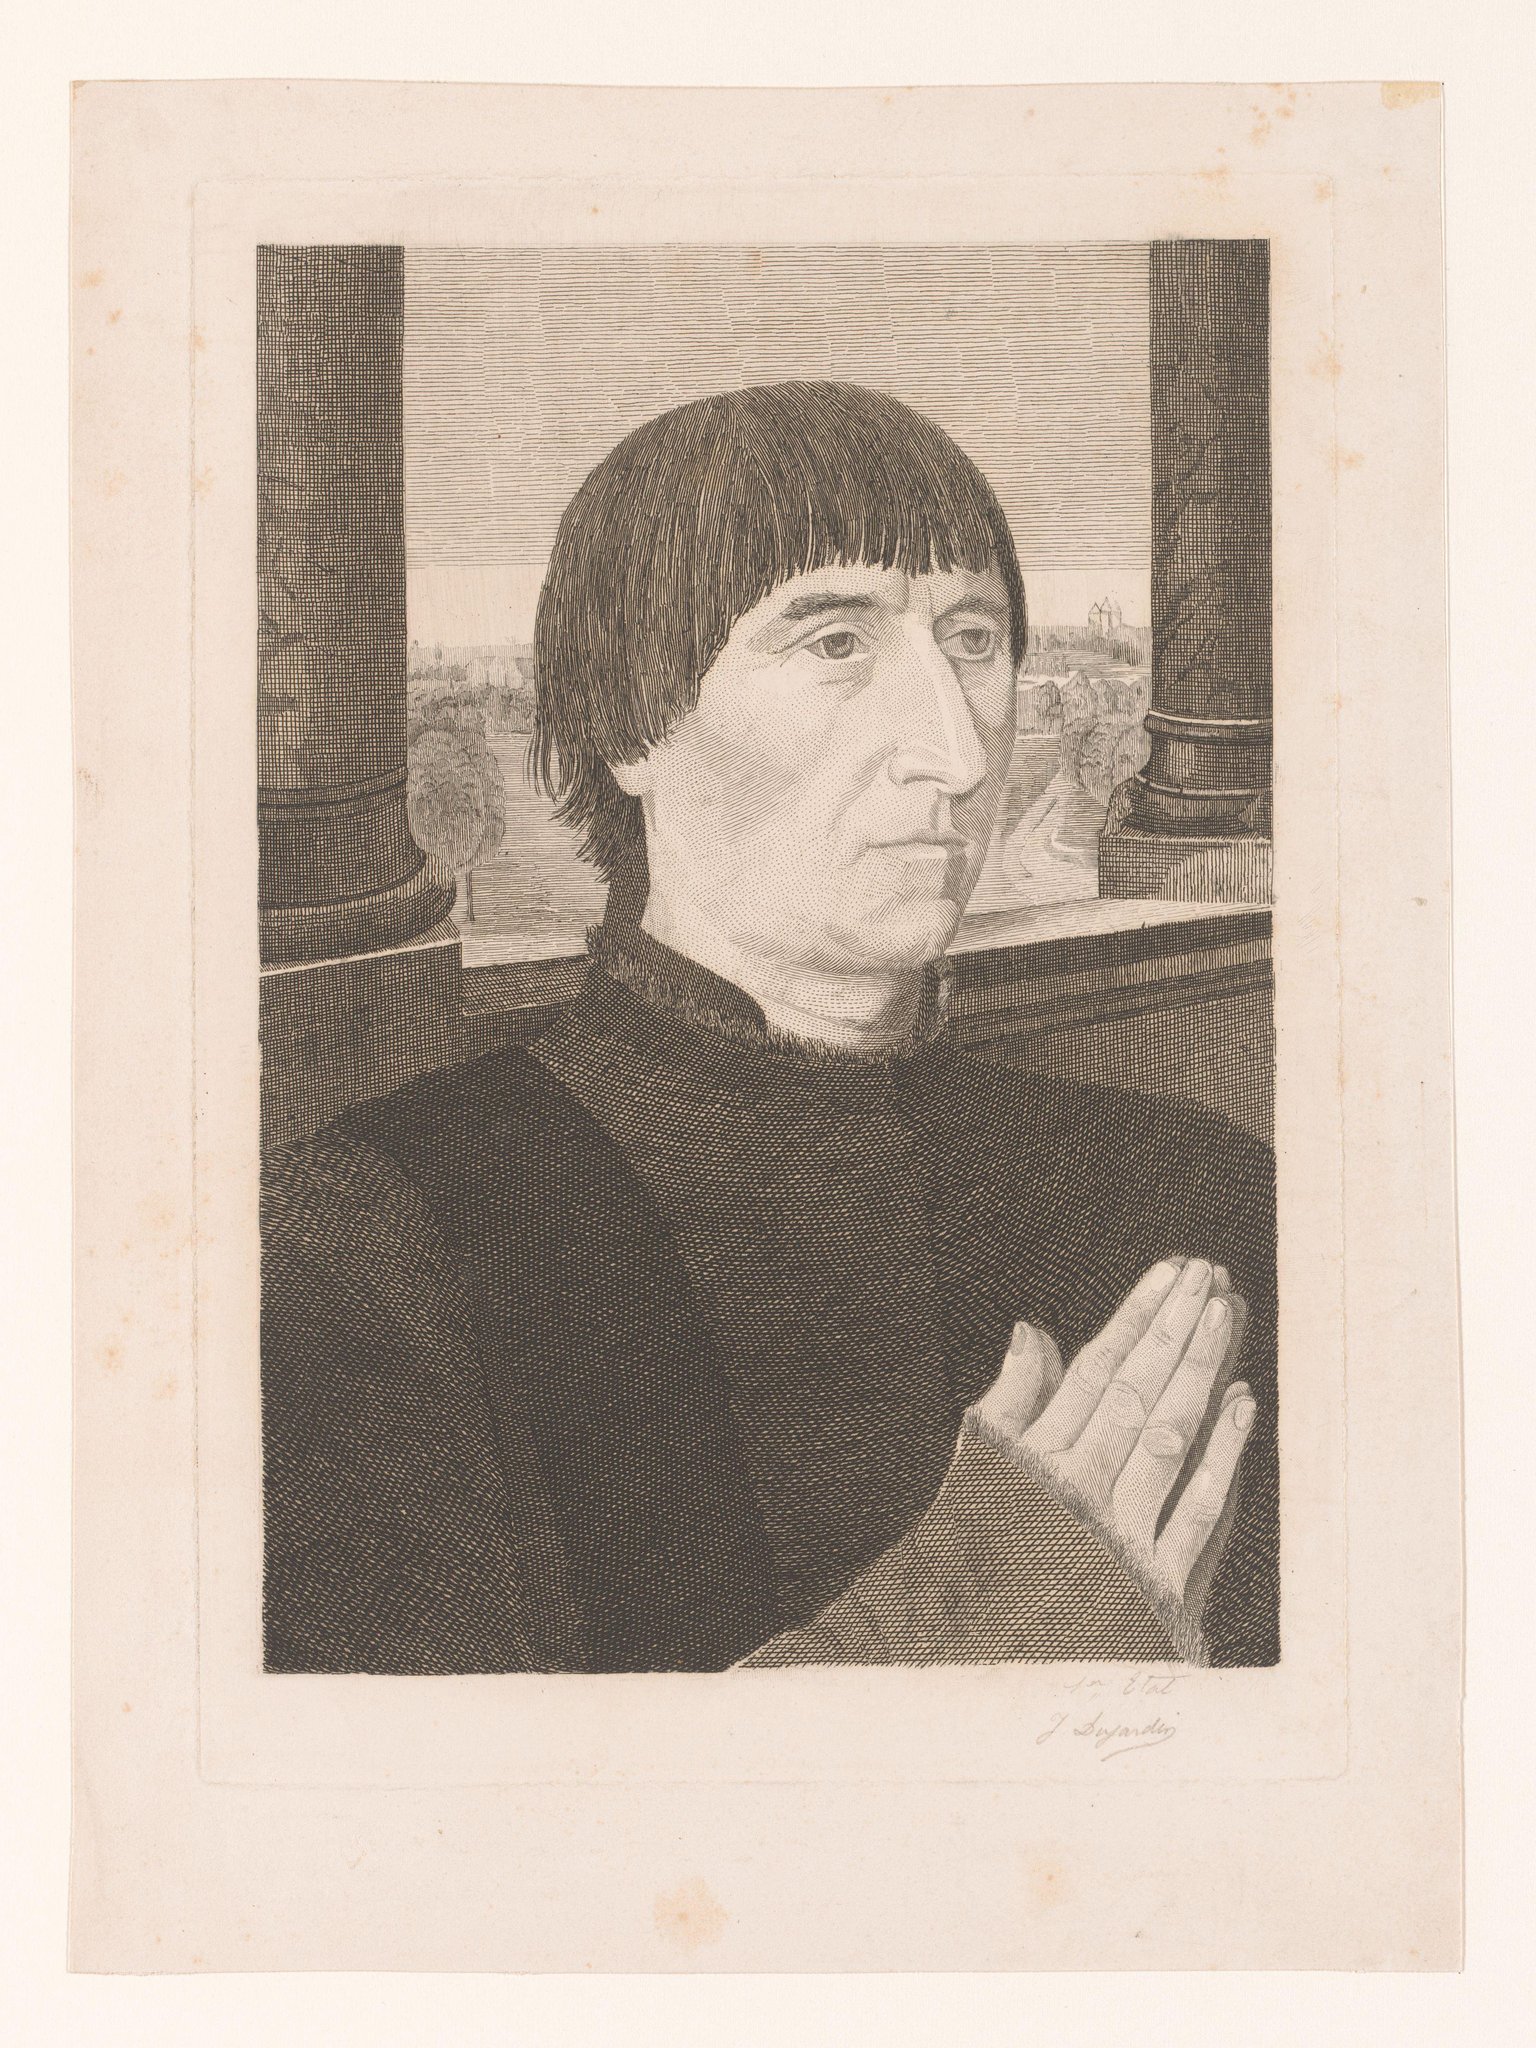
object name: print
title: Donorportret van Willem Moreel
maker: joseph dujardin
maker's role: print maker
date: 1875-1899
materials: paper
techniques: etching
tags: bruges, adult man, historical persons, hands folded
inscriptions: collector's mark: Lugt 2228, inscription: ‘1e Etat’